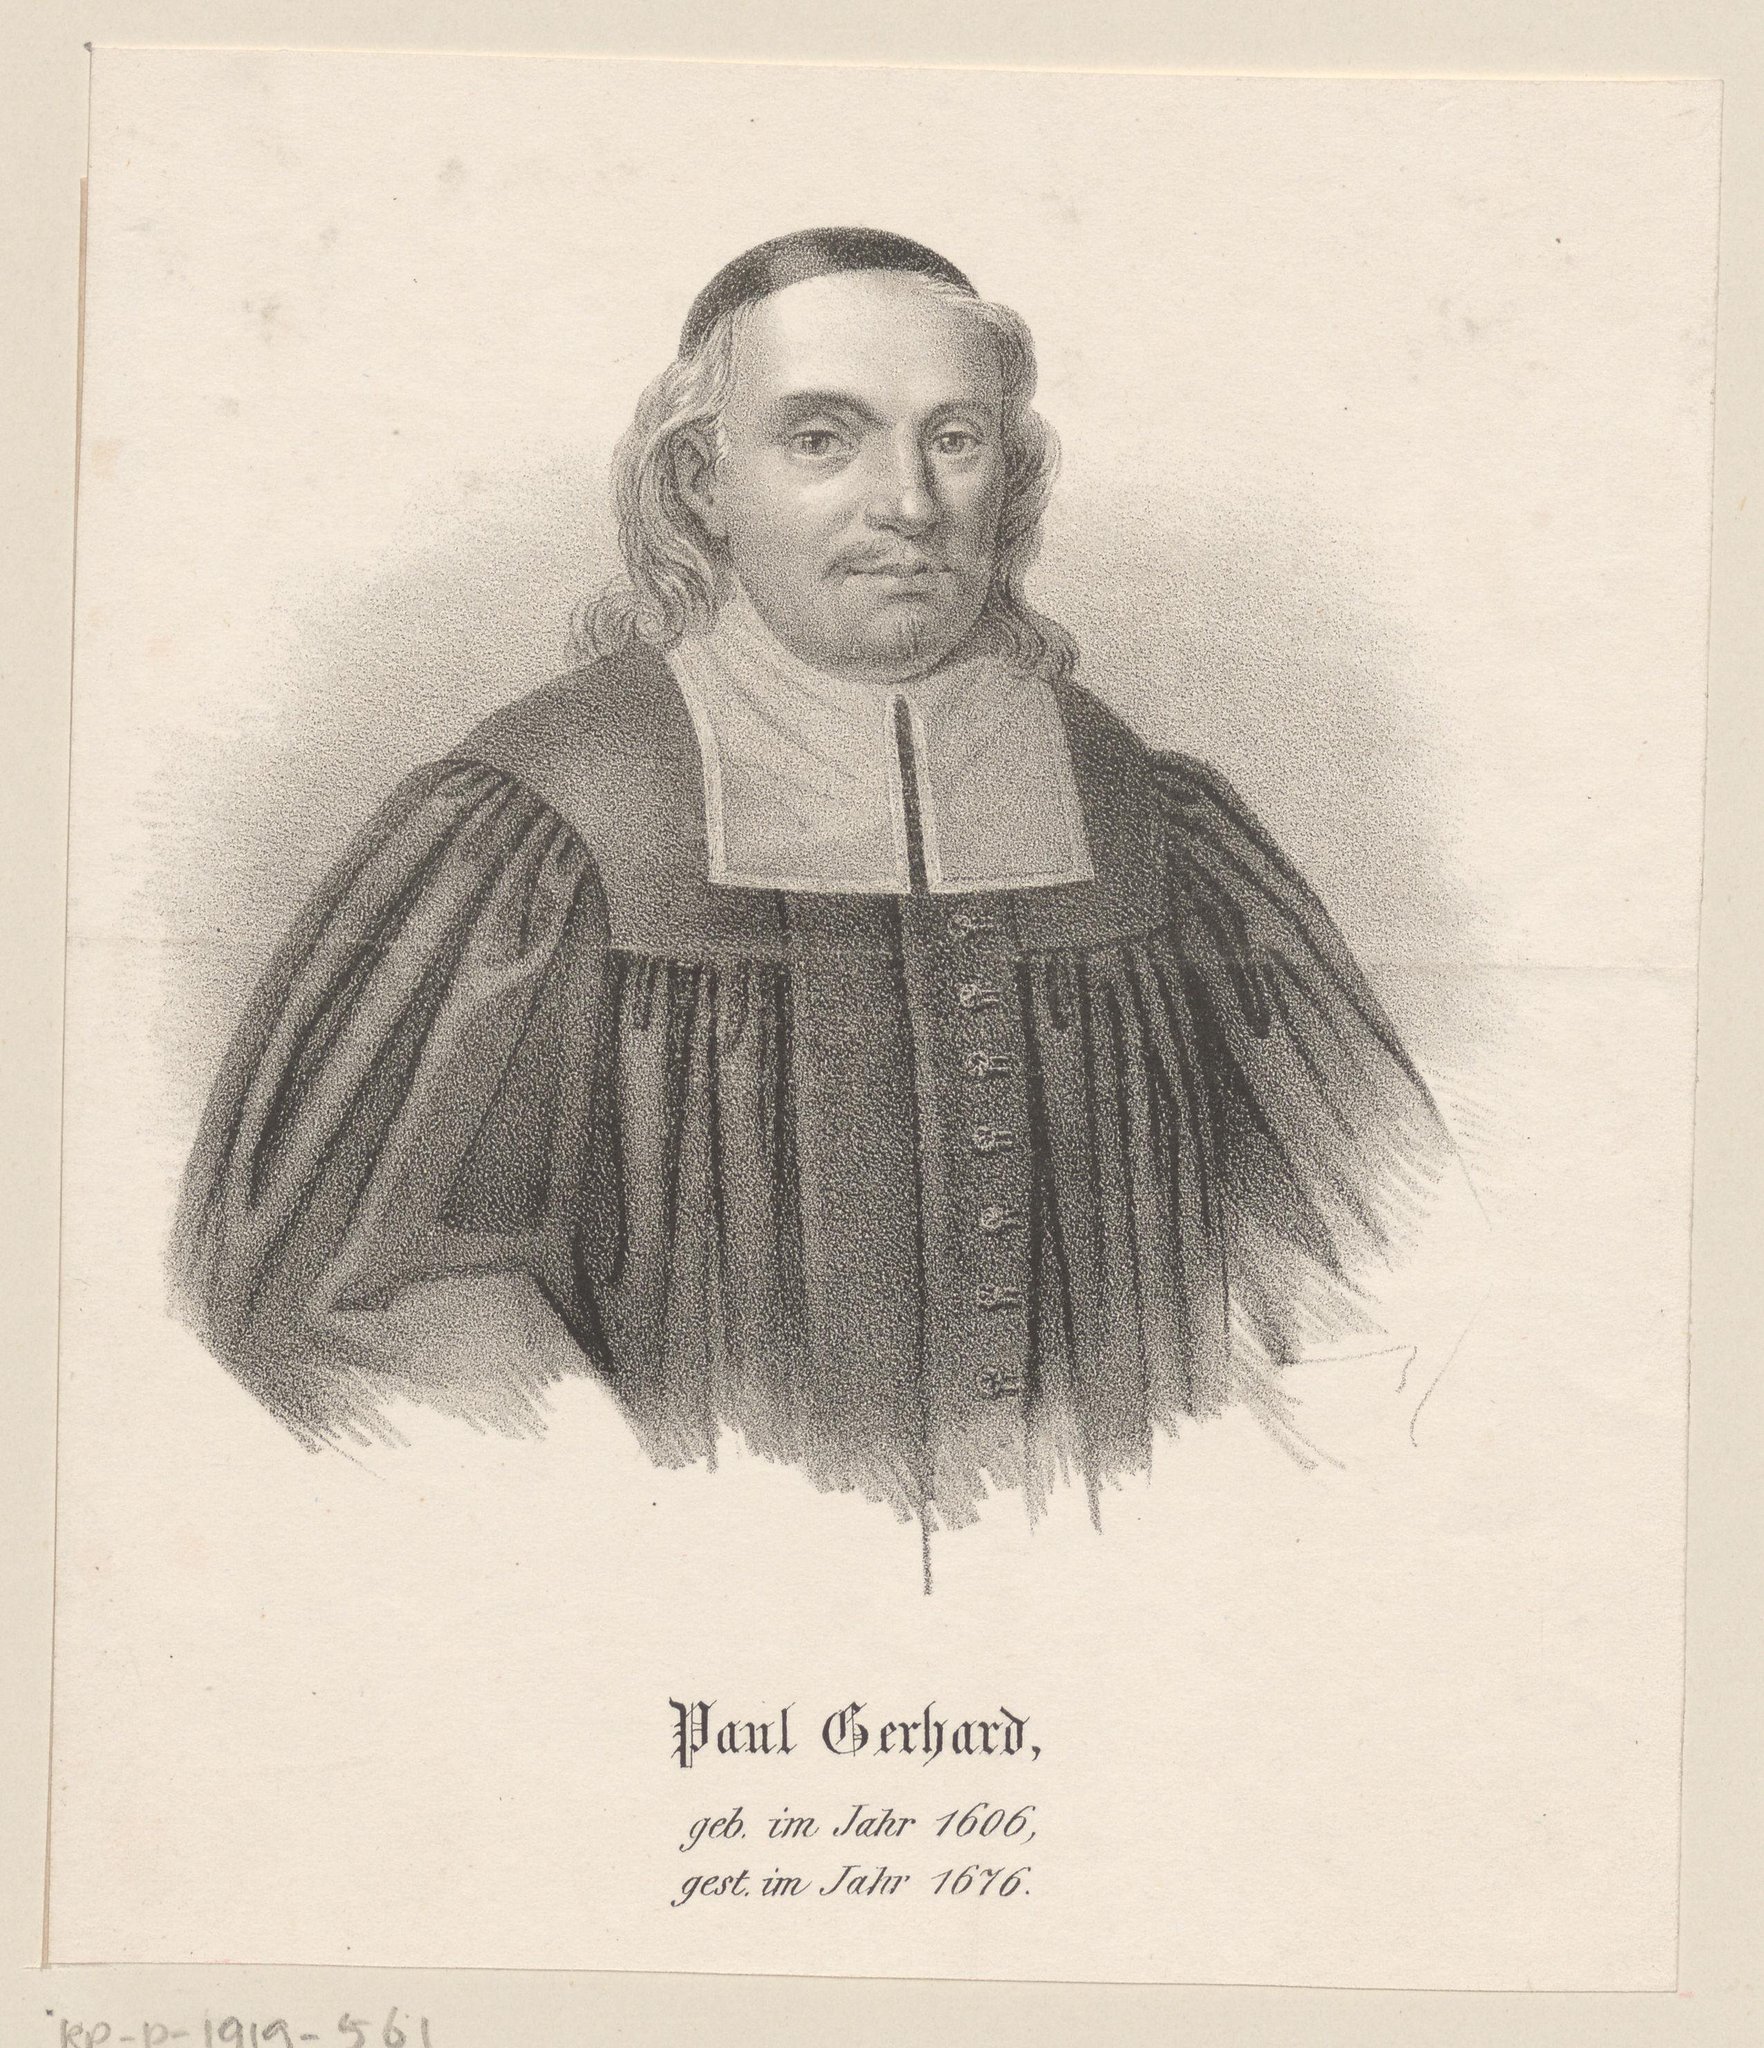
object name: print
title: Portret van Paul Gerhardt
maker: Anonymous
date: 1800-1900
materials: paper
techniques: lithograph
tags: historical persons, writer, poet, author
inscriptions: collector's mark: Lugt 2228